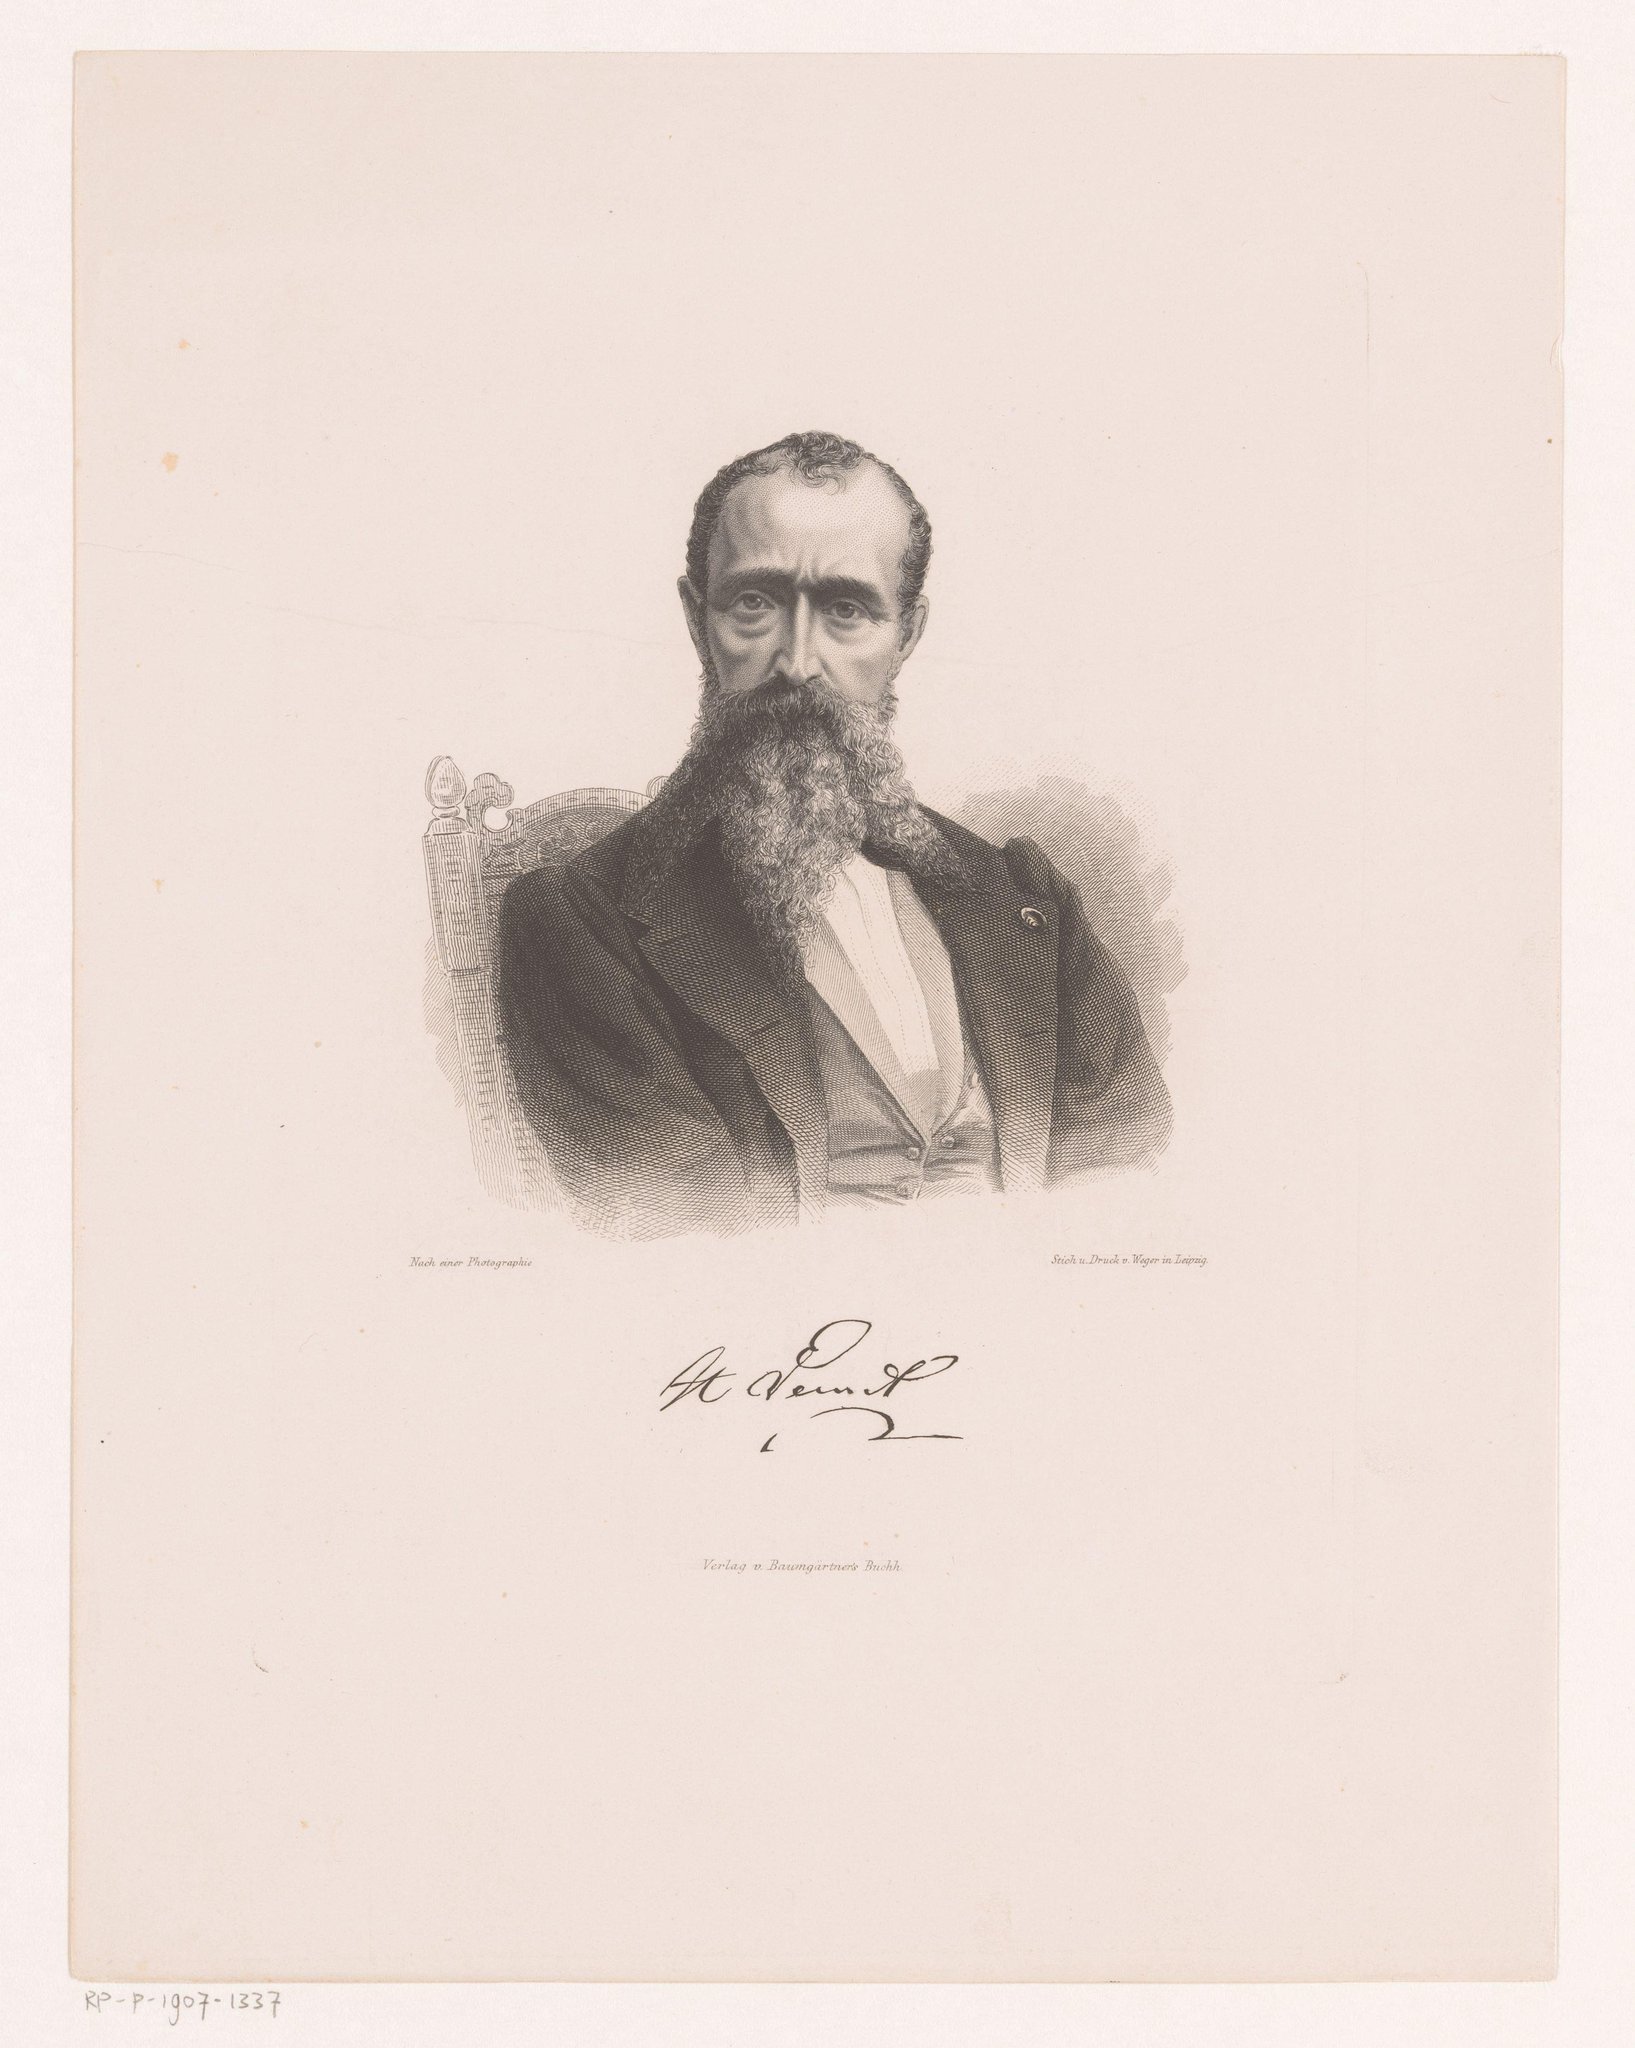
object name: print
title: Portret van Horace Vernet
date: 1849-1892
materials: paper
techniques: engraving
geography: leipzig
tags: paris, painter, print maker, draughtsman, horace vernet, historical persons, portrait, self-portrait of artist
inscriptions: collector's mark: Lugt 2228